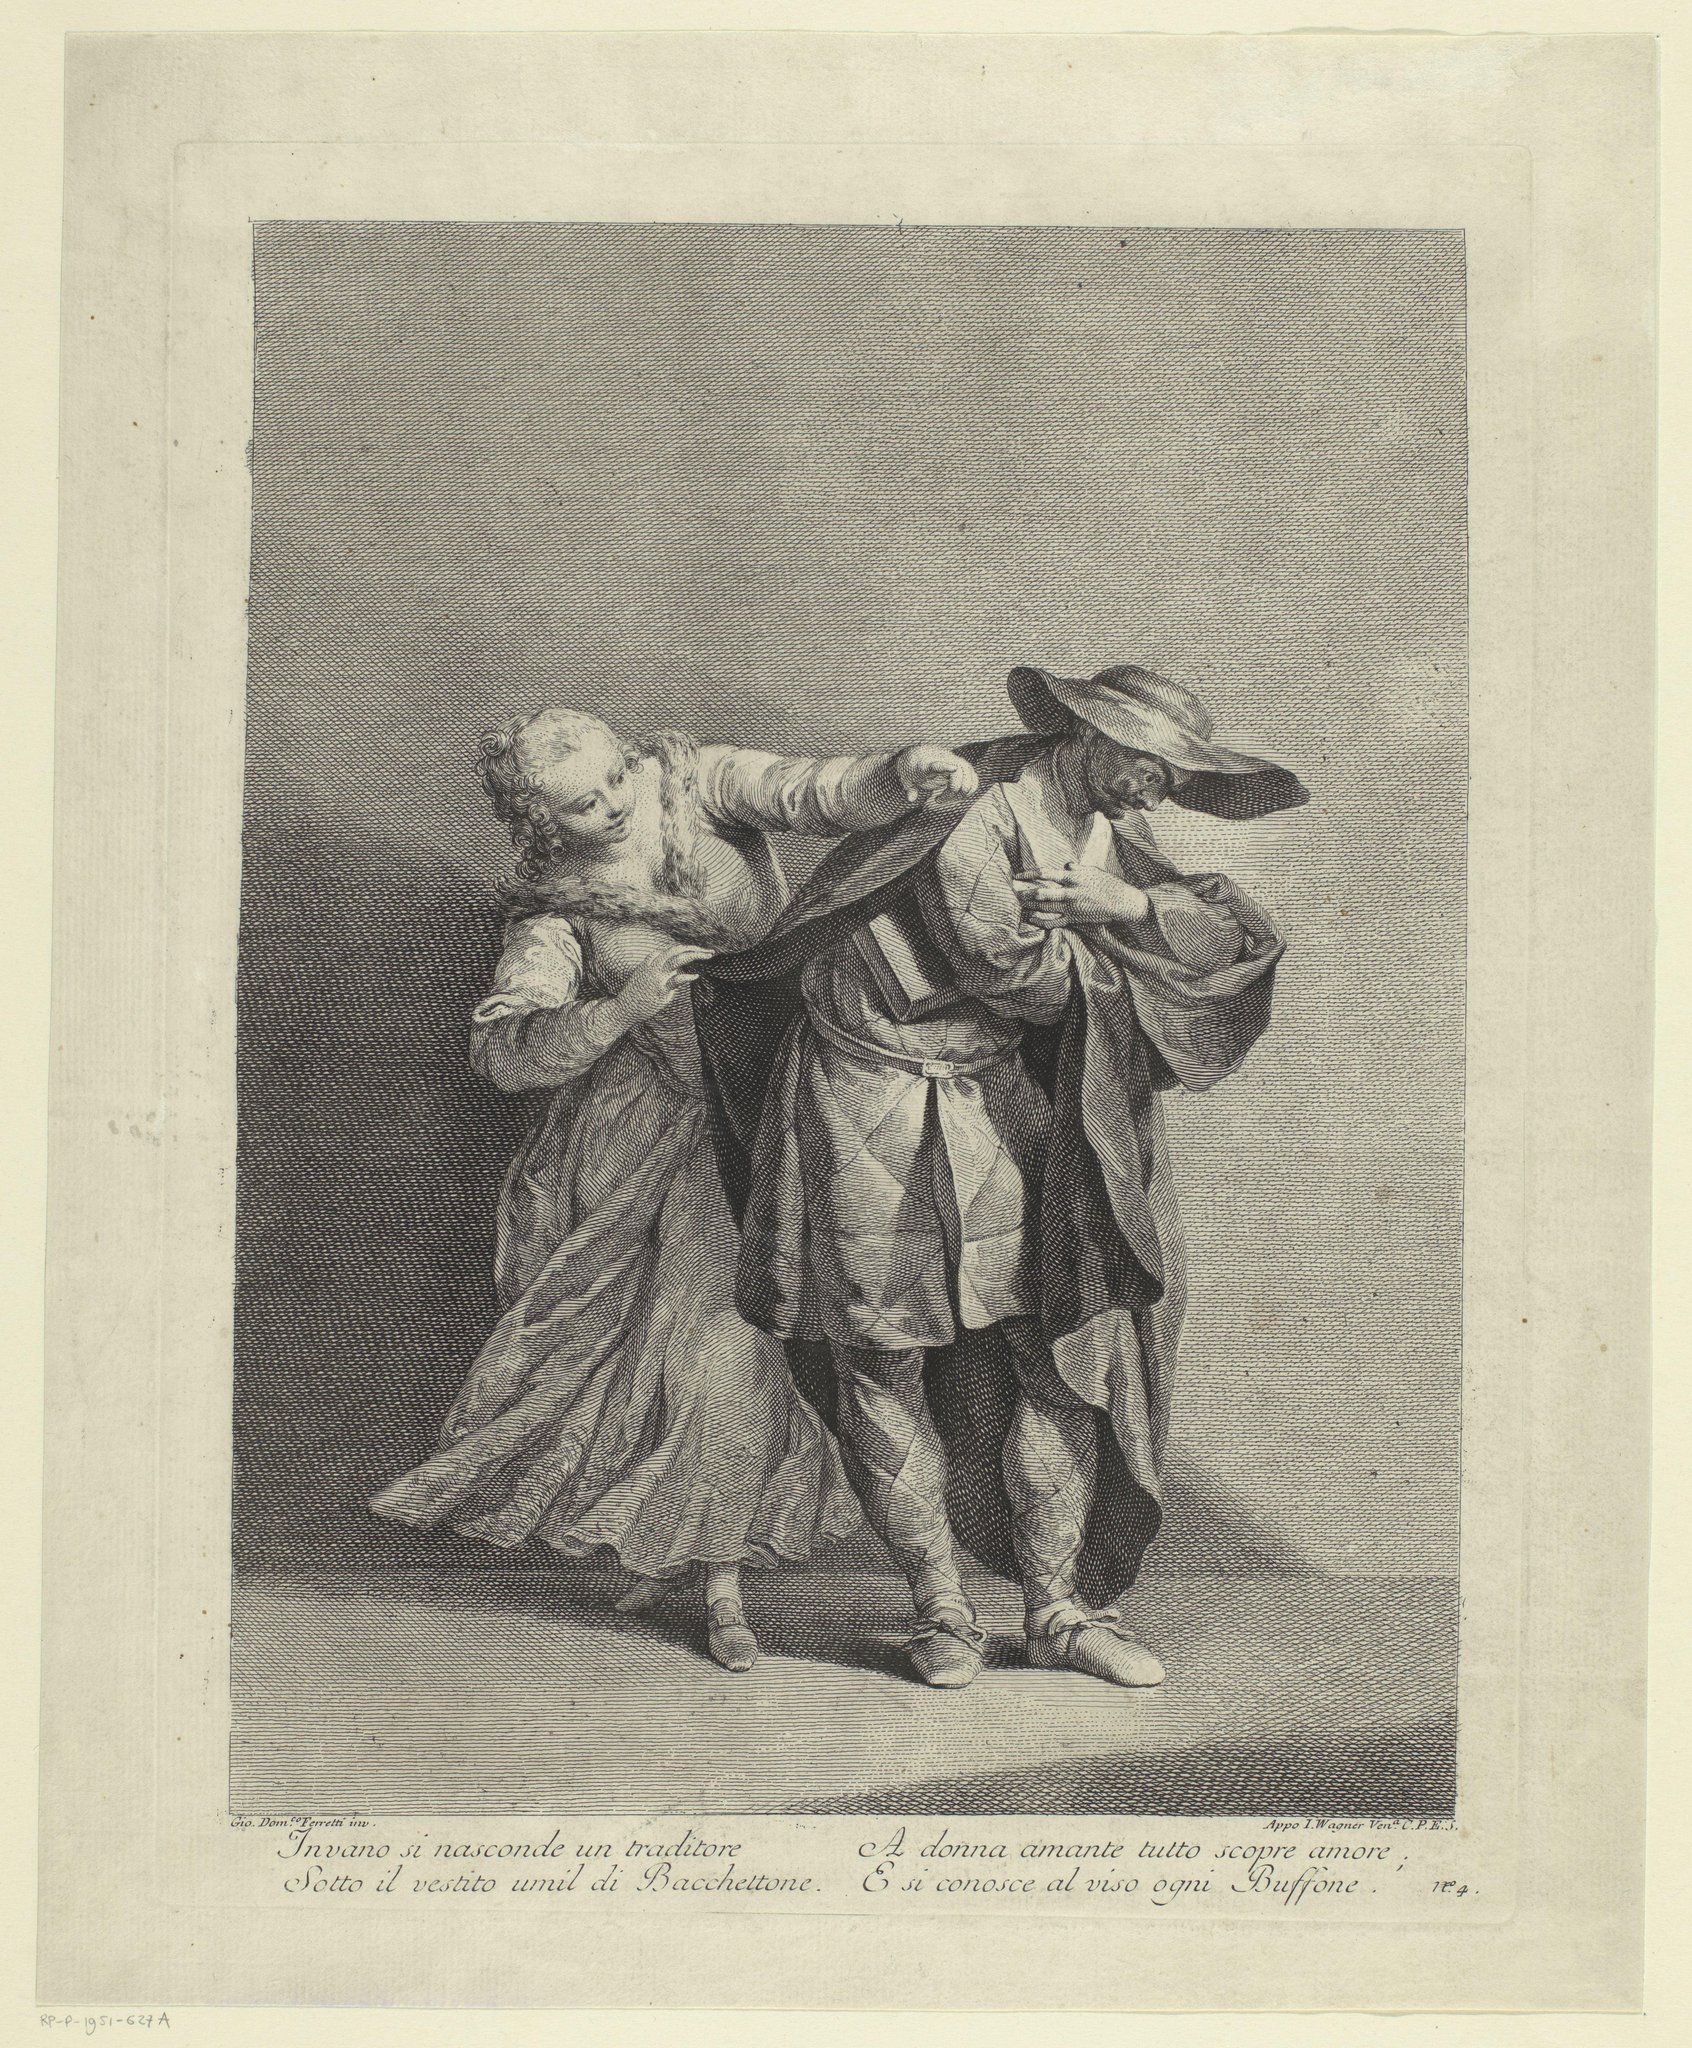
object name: print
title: Voorstellingen met harlekijnen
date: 1739-1780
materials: paper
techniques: engraving, etching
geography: venice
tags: adolescent, young woman, maiden, types in 'commedia dell'arte': harlequin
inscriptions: collector's mark: Lugt 2228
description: Prent maakt deel uit van een serie van vier prenten met voorstellingen met harlekijnen. In de collectie van het Rijksmuseum bevinden zich twee van de vier prenten.